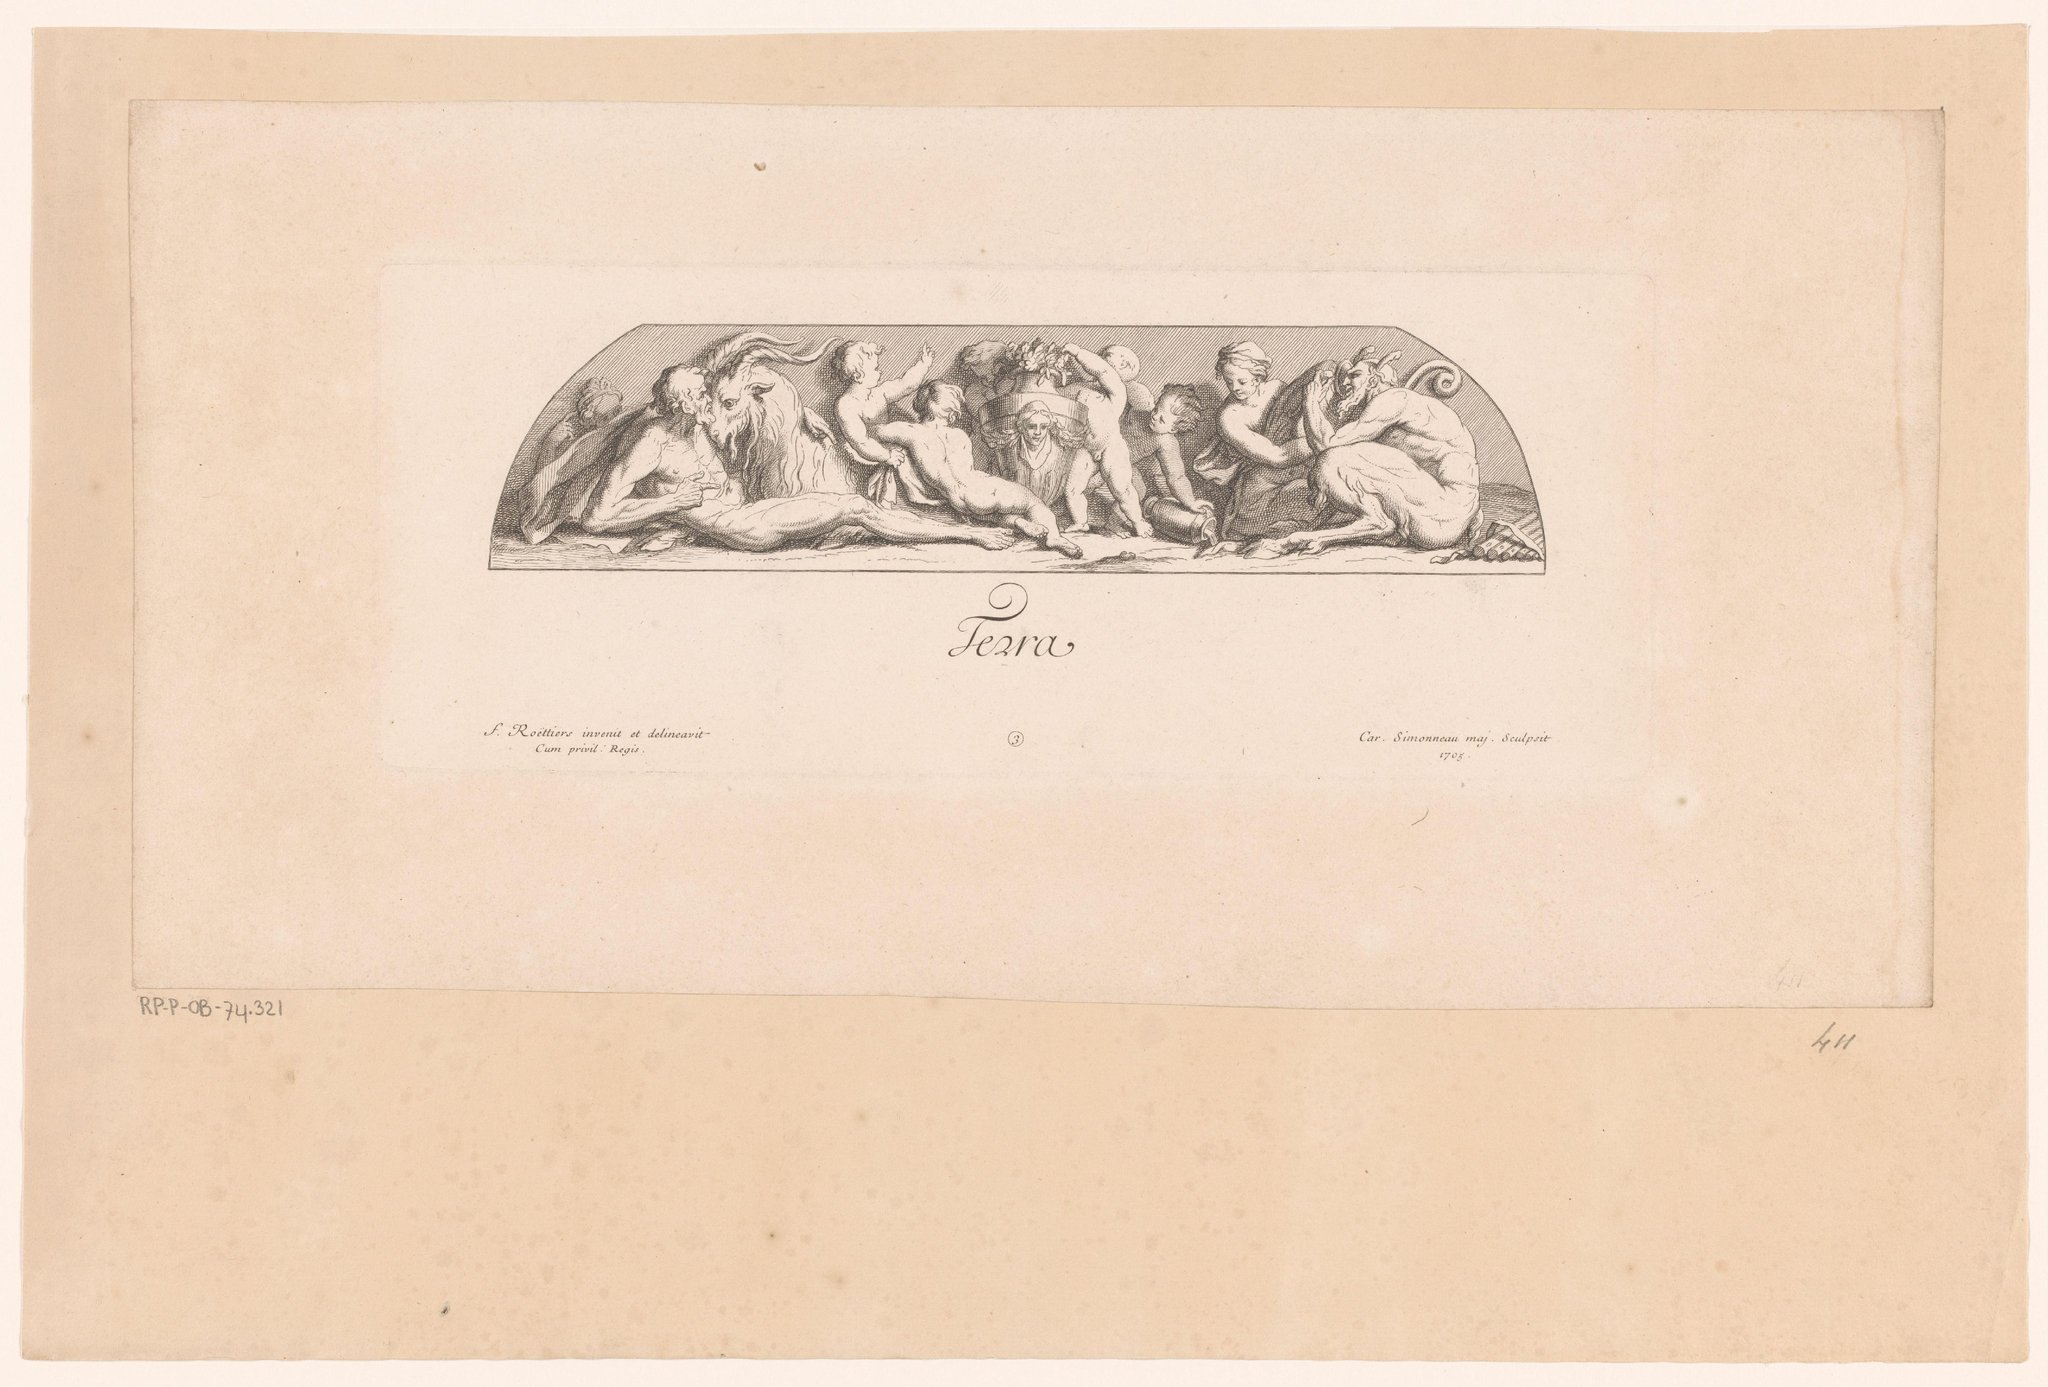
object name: print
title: Terra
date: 1705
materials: paper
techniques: engraving, etching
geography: france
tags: 'terra', 'carro della terra' (ripa)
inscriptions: collector's mark: Lugt 240